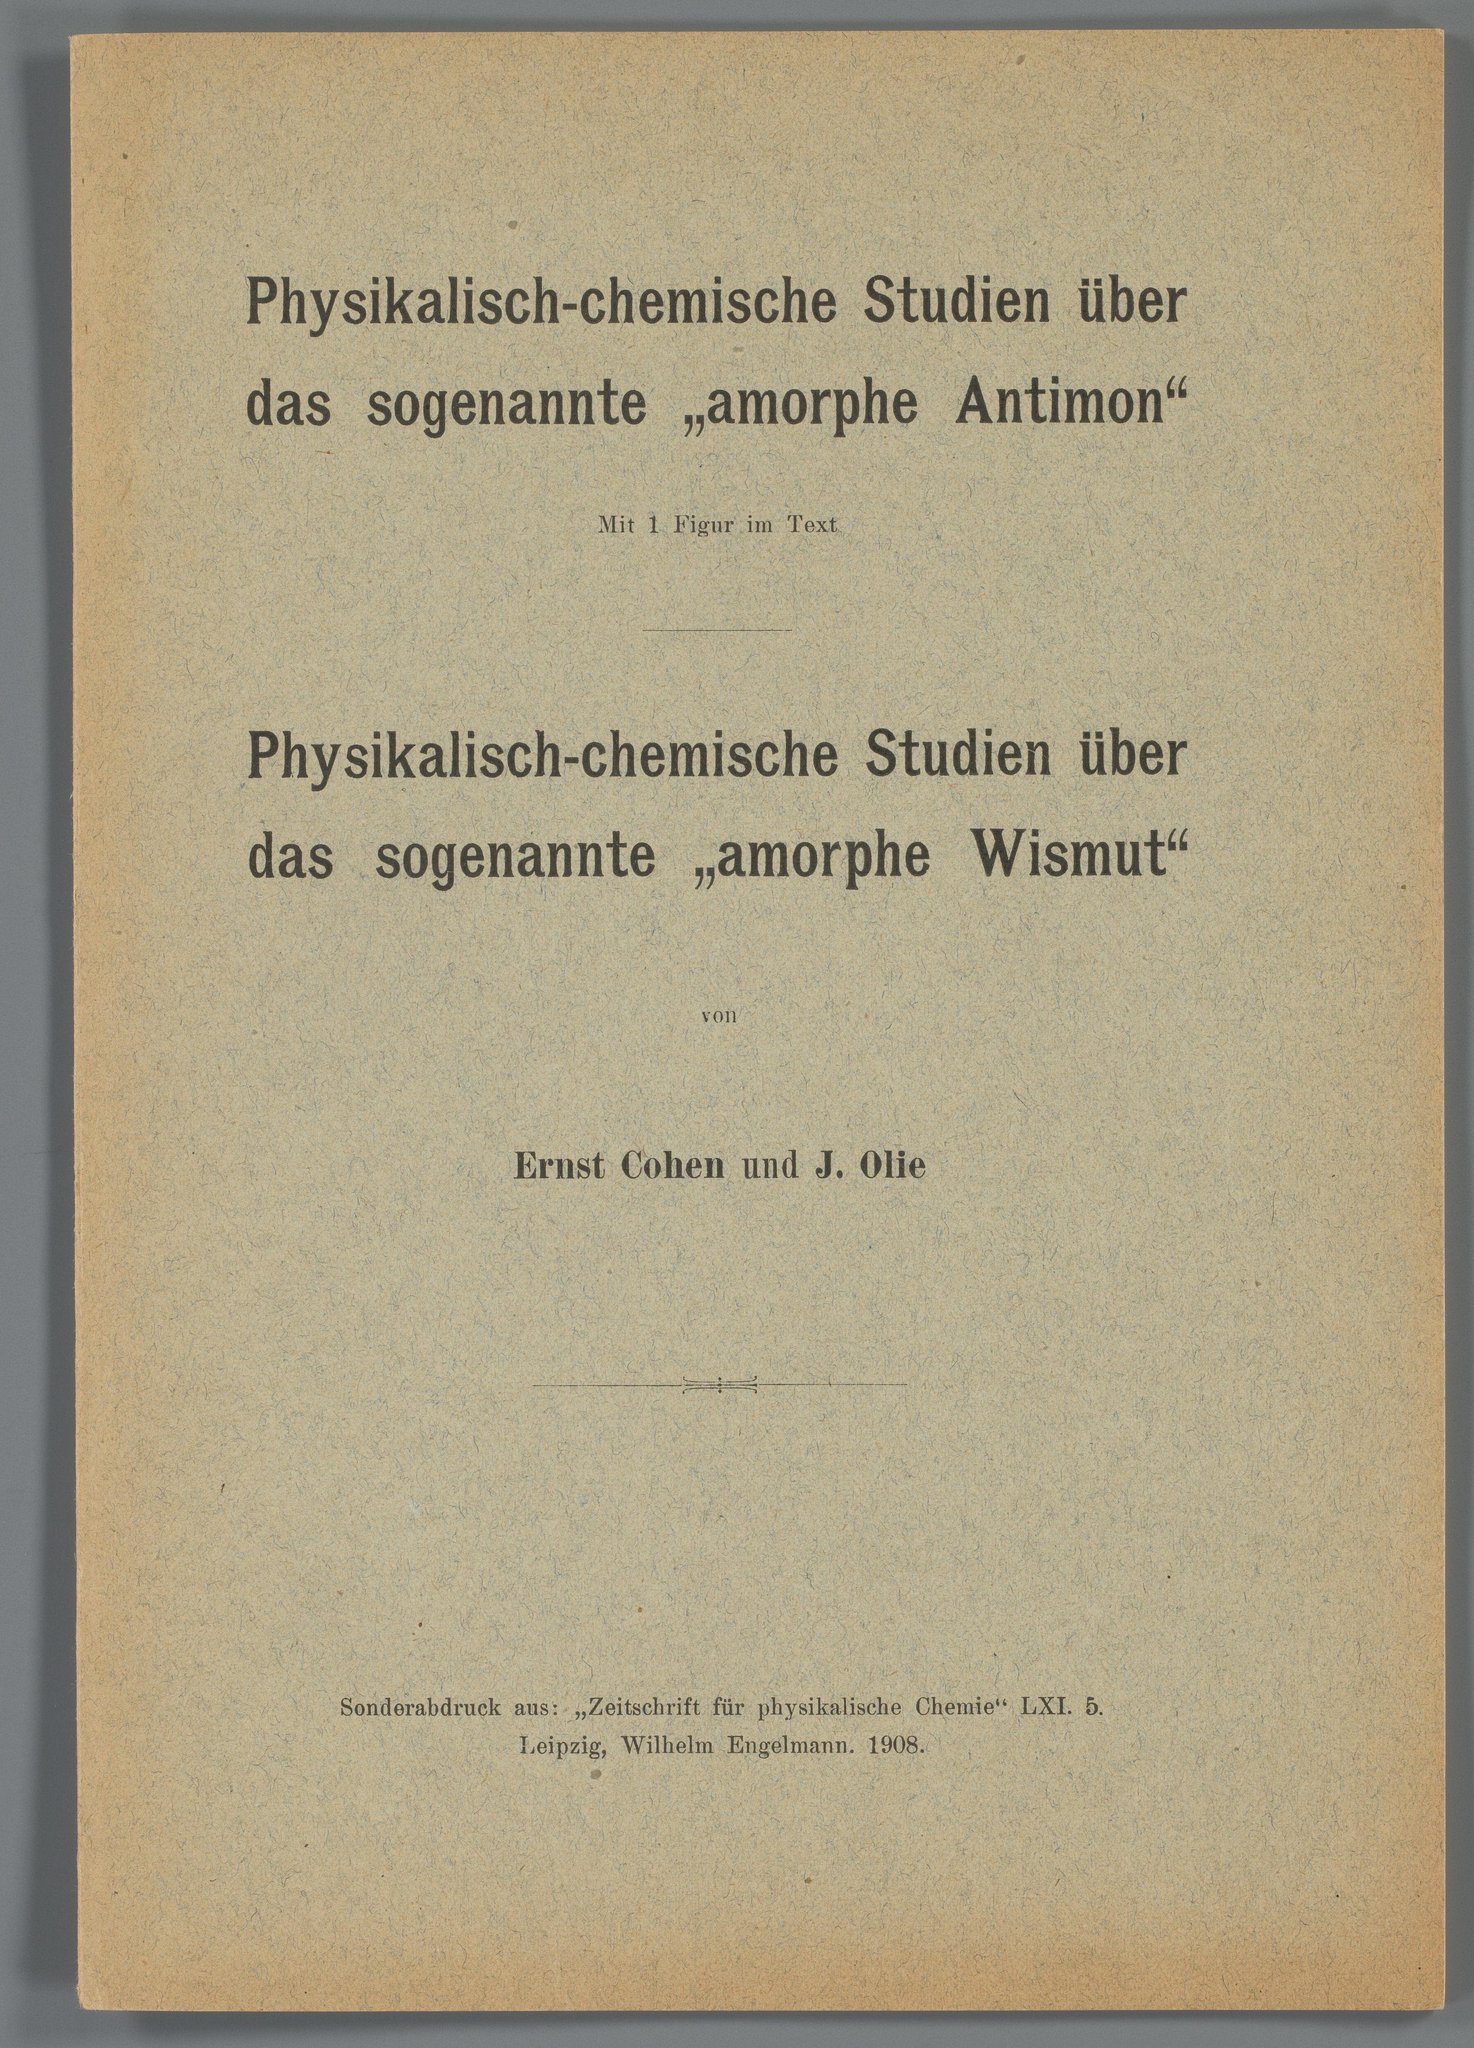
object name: offprint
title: Physikalisch-chemische Studien über das sogenannte "amorphe Antimon". Physikalisch-chemische Studien über das sogennante "amorphe Wismut"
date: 1908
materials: paper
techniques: letterpress printing, printing block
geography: utrecht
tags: printed matter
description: Overdruk uit het 'Zeitschrift für physikalische Chemie', LXI. 5, 1908.